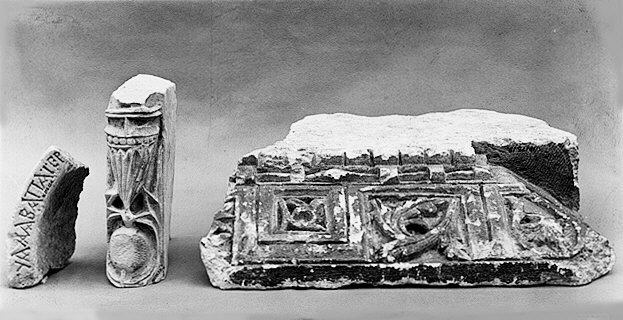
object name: fragment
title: Fragment of an Inscribed Relief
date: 201-1200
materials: limestone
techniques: carving, relief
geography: egypt